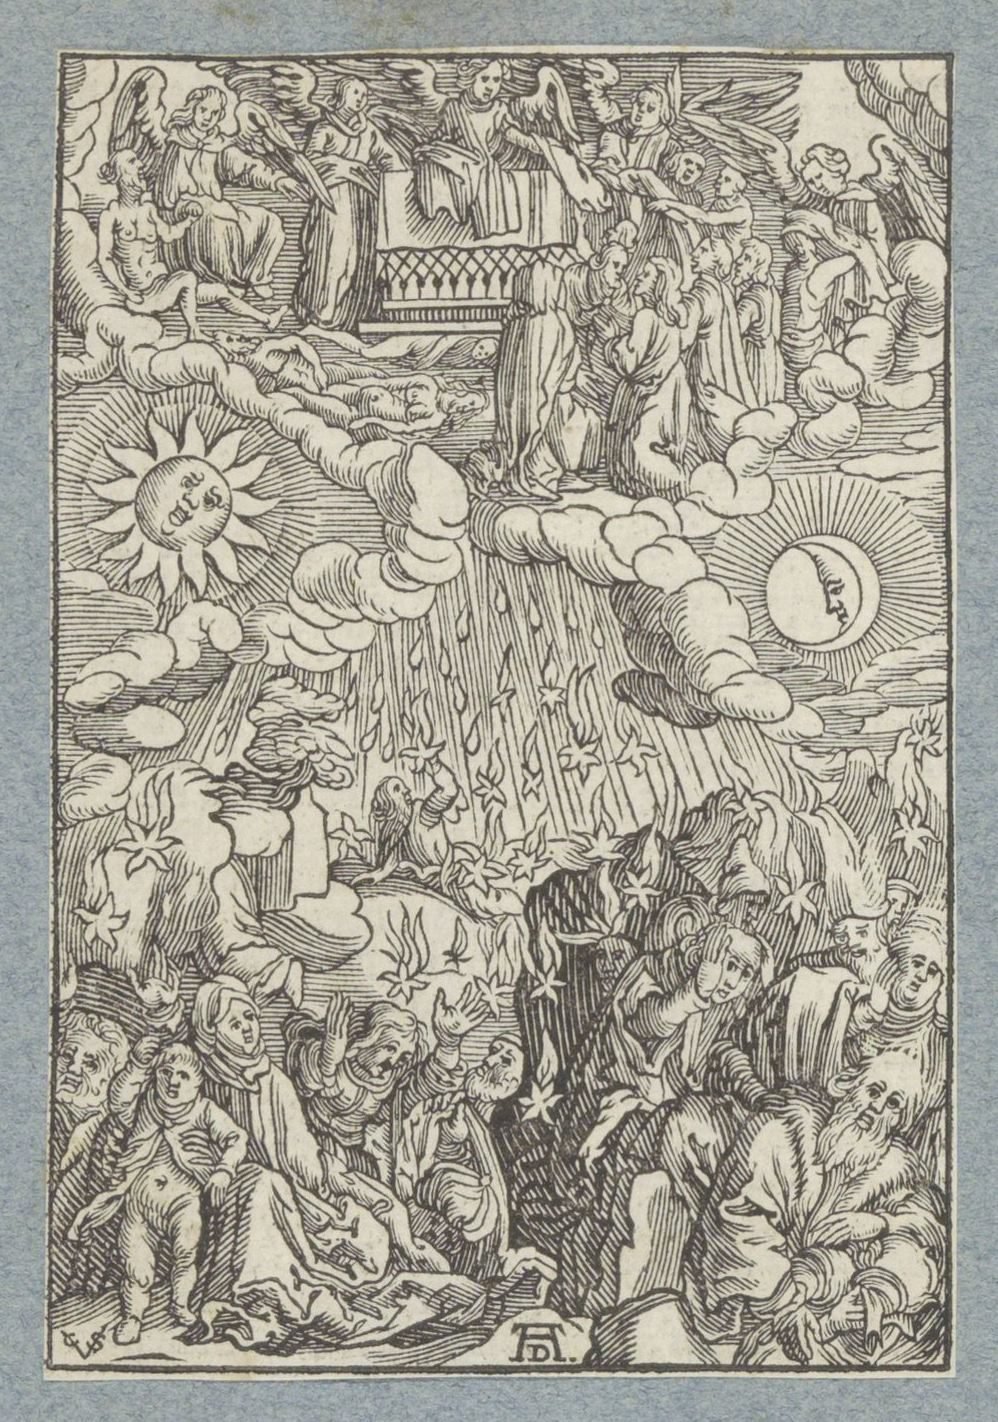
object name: book illustration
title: Het openen van het vijfde en het zesde zegel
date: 1629-1646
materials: paper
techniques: letterpress printing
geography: nuremberg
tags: opening of the sixth seal: a great earthquake, the sun turns black, the moon red as blood, and the stars fall on earth; mankind hiding in caves, opening of the fifth seal: white robes are given to (the souls of) the martyrs under the altar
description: De prent is afkomstig uit een van de uitgaven van P.J. Paets uit Amsterdam. De prent wordt mogelijk al gebruikt in: Der Zielen Lust-hof. Leuven, I.Jacbosz voor P.J. Paets [= Amsterdam, P.J. Paets], 1629. Ze komt in ieder geval voor in: Het Nieuwe Testament ons Salichmaeckers Jesu Christi. Amsterdam, P.J. Paets, 1646.